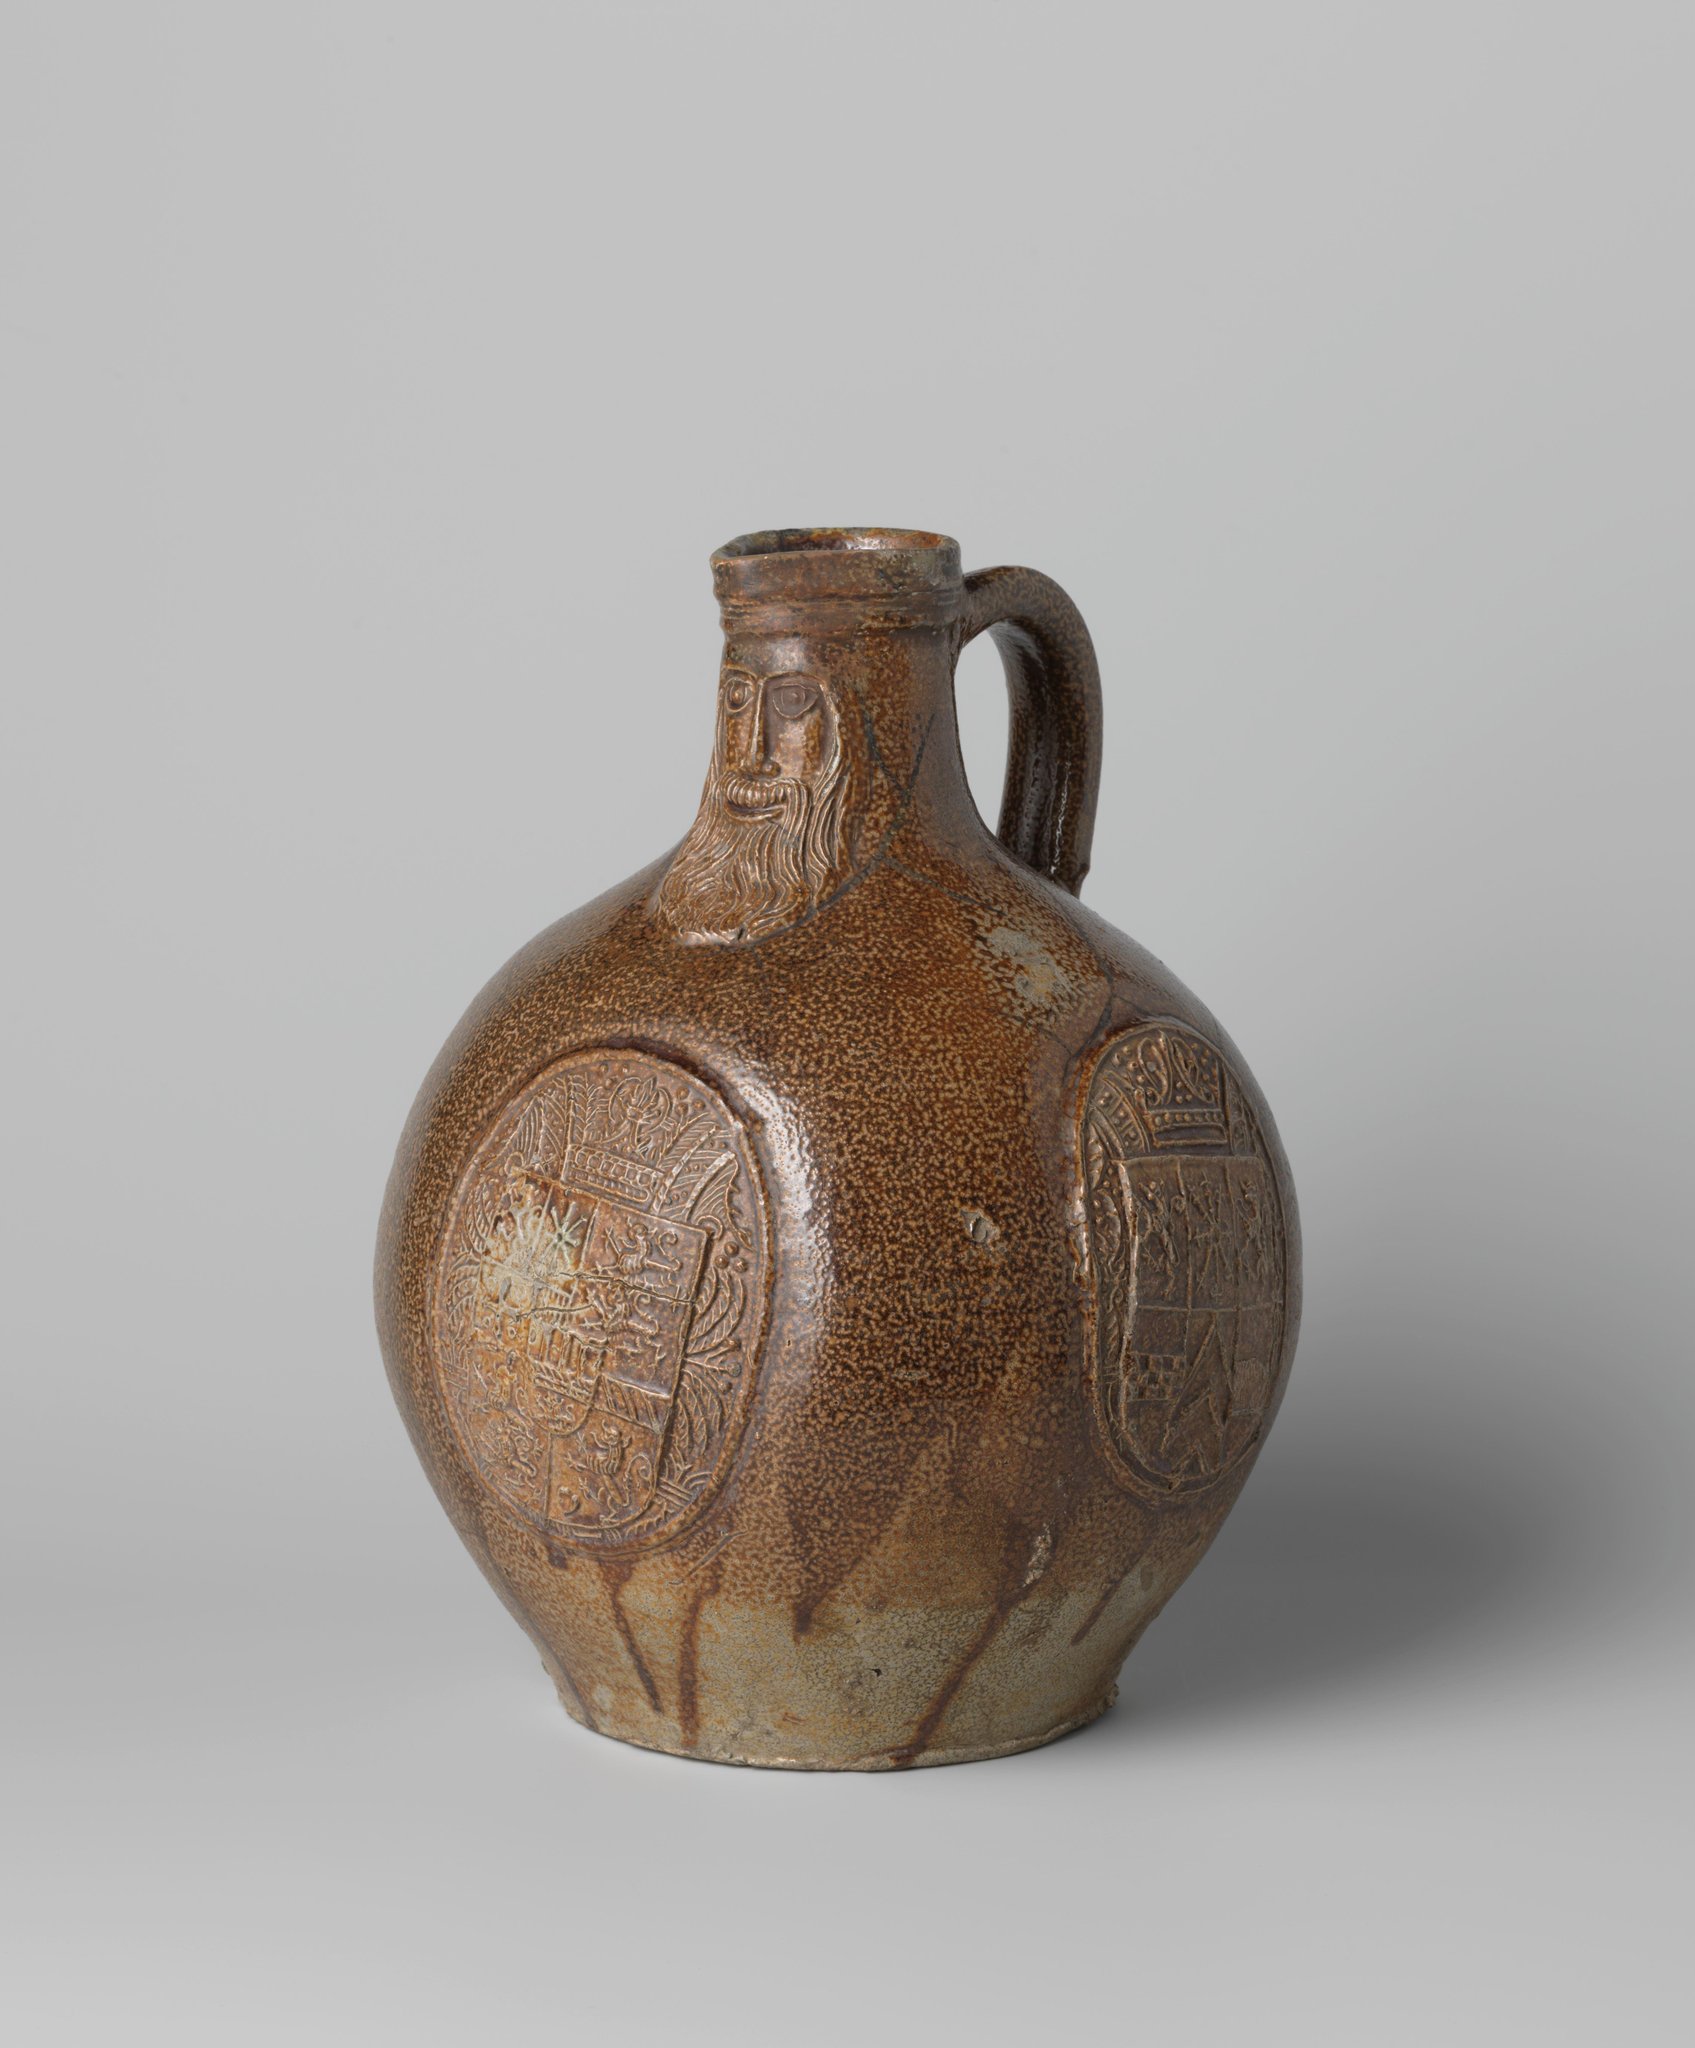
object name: jug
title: Jug (Bartmann jug) with coats of arms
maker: Anonymous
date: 1550-1624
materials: engobe, glaze, stoneware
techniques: firing, forming, relief, turning, vitrification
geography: frechen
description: Kruik (baardmankruik) van steengoed op standvlak met een bolvormig lichaam en smalle nek met een geknepen tuit. Het C-vormige oor is bevestigd aan de nek en de schouder. Profielen op de nek. Bedekt met een bruine engobe. Driemaal een gedrukt en opgelegd medaillon met drie verschillende gekroonde wapens omgeven door bladranken. Op de nek, doorlopend op de schouder, een baardman. Frechen.